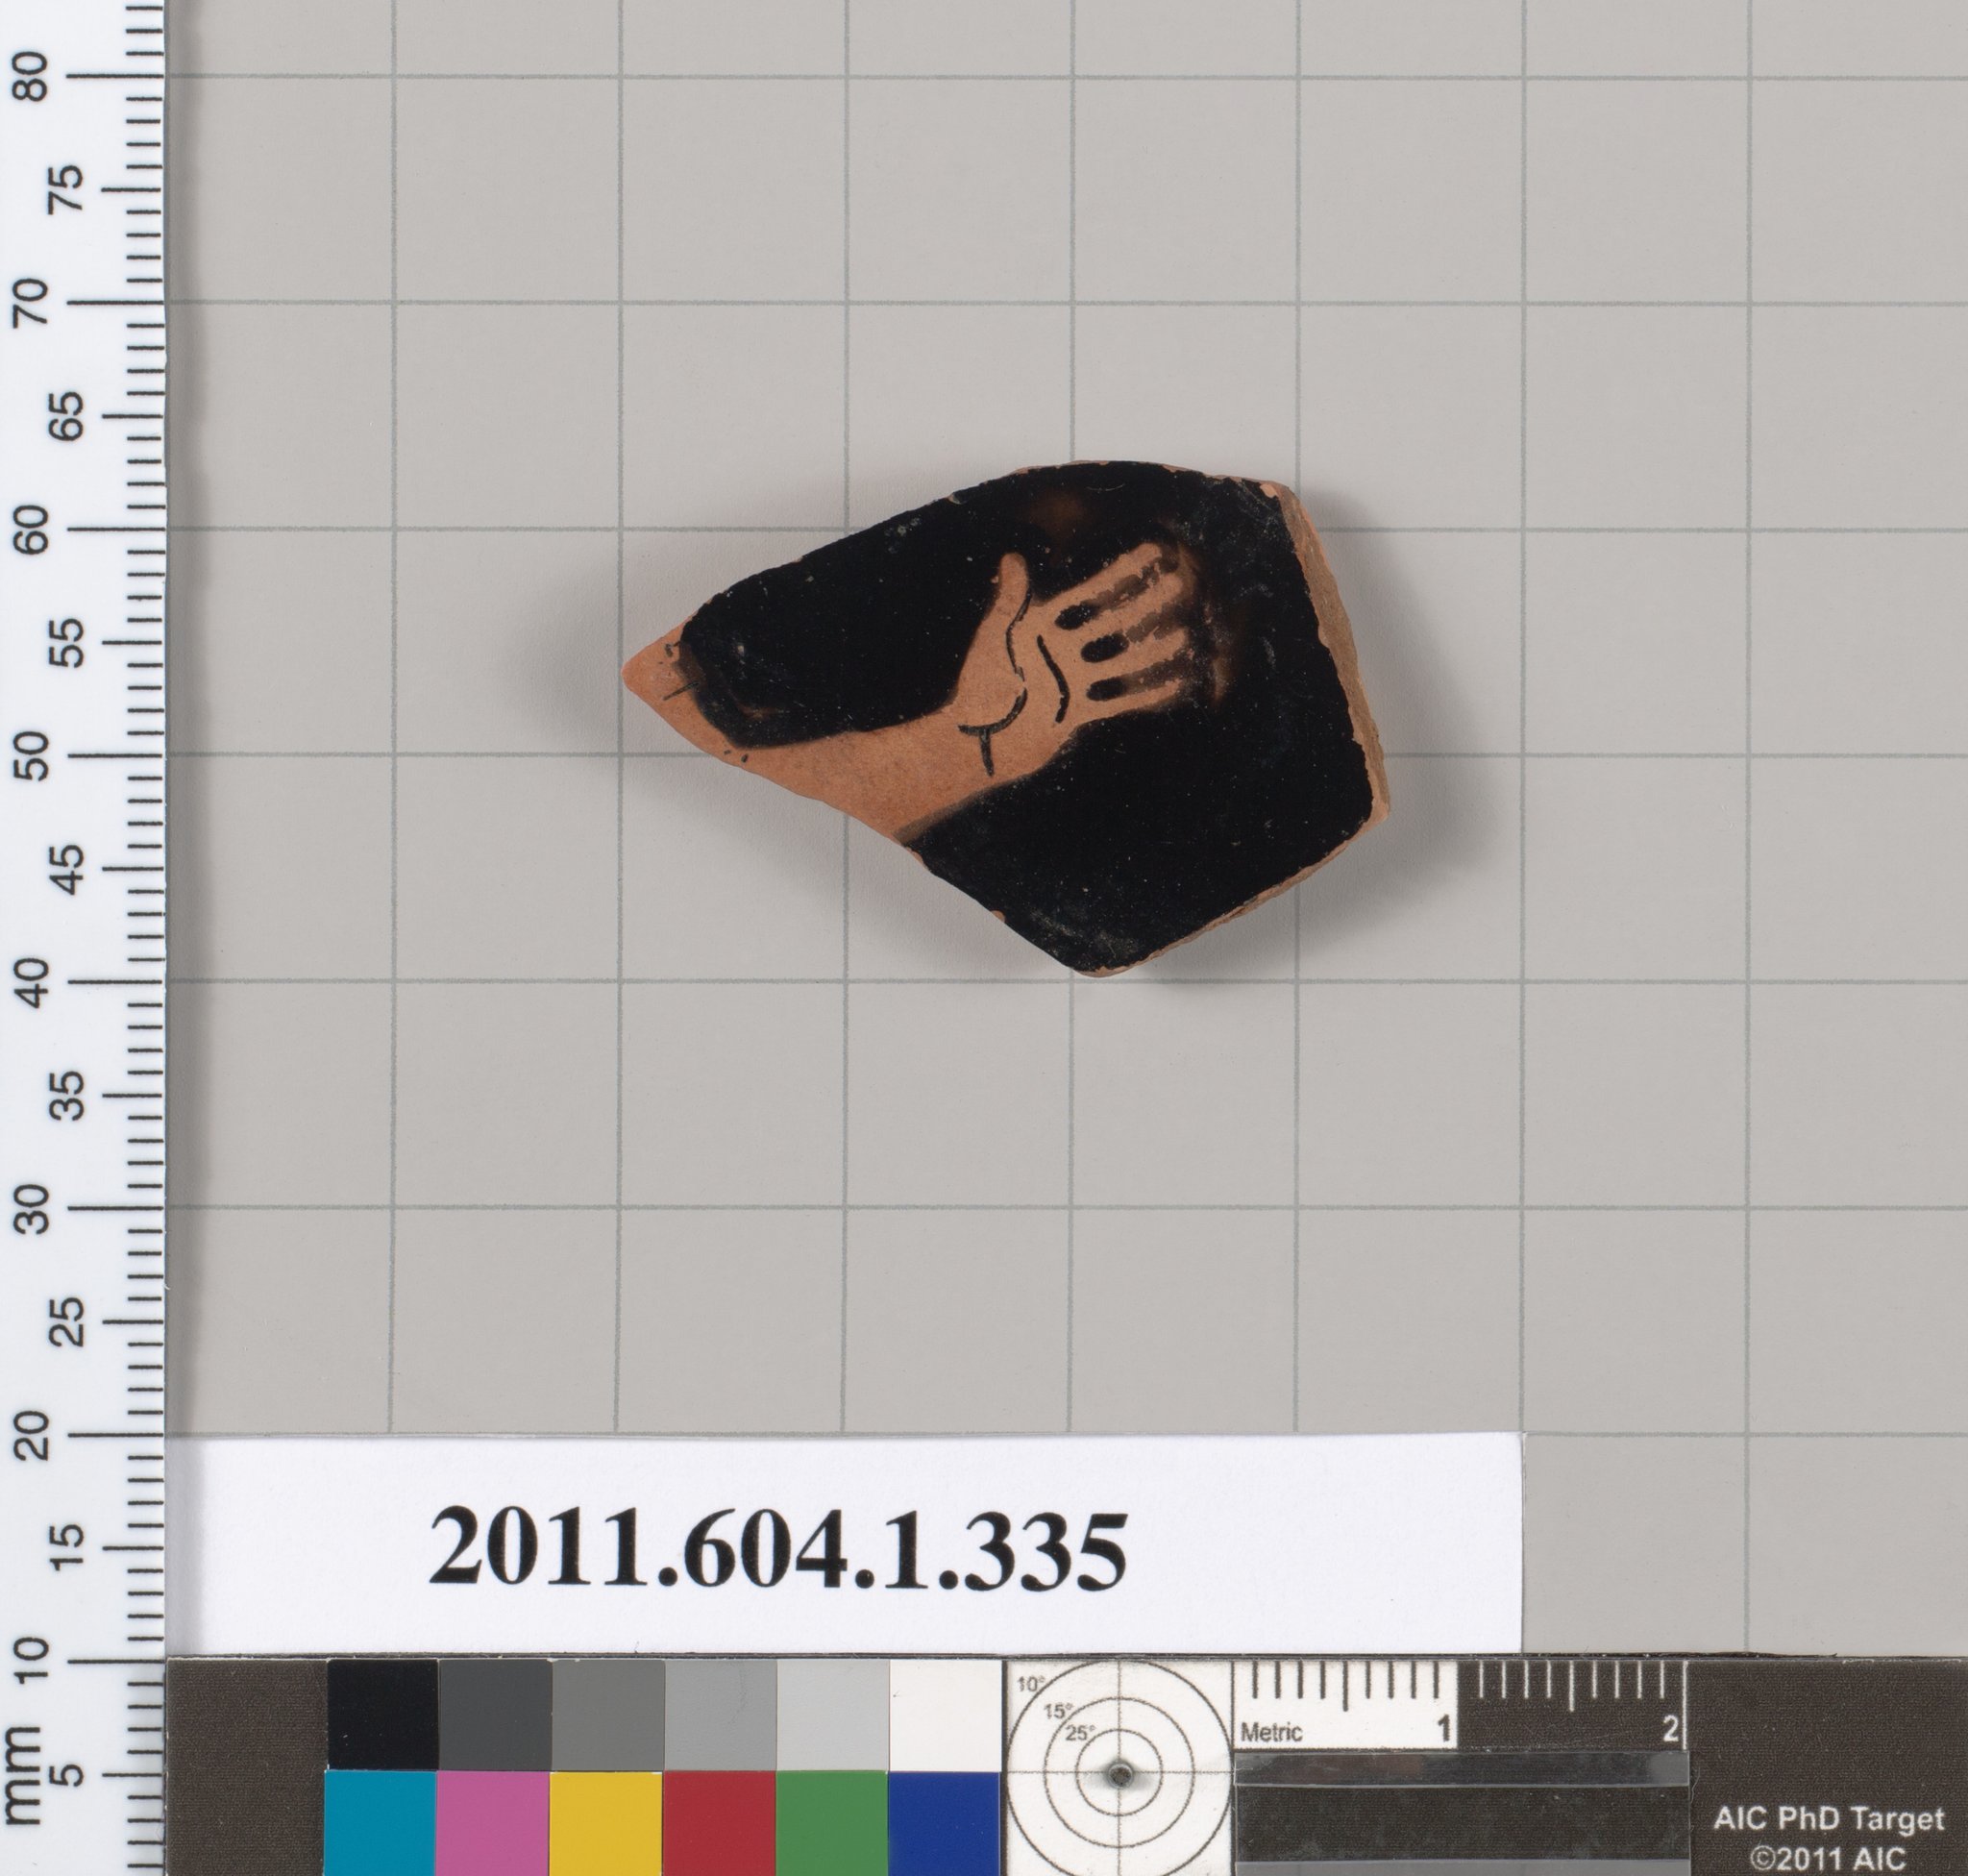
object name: kylix fragment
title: Terracotta fragment of a kylix (drinking cup)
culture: greek, attic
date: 475-451 BCE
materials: terracotta